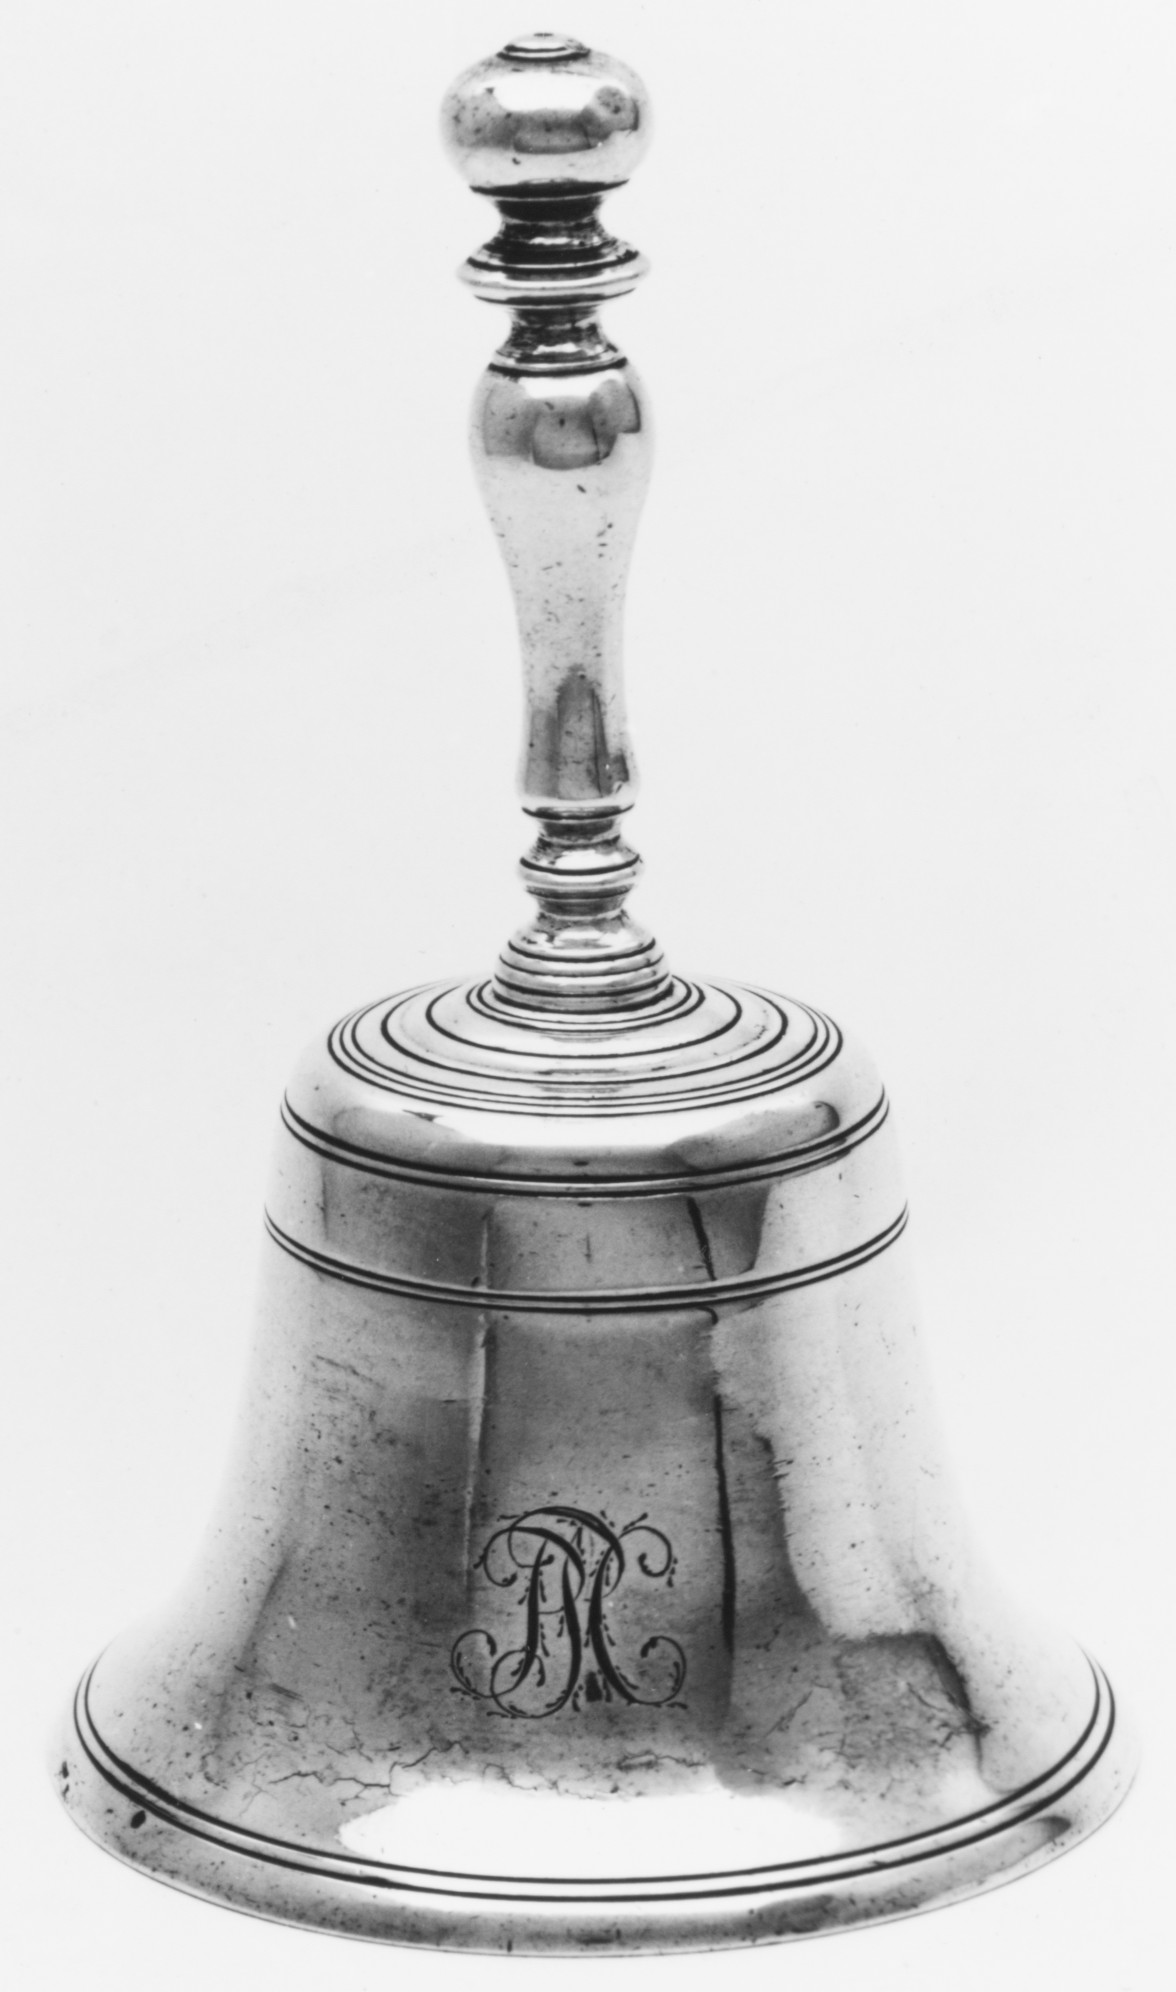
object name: bell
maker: jean-baptiste-joseph leroux (or le roux)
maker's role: maker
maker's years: 1716-1815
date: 1779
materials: silver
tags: musical instruments,insignia